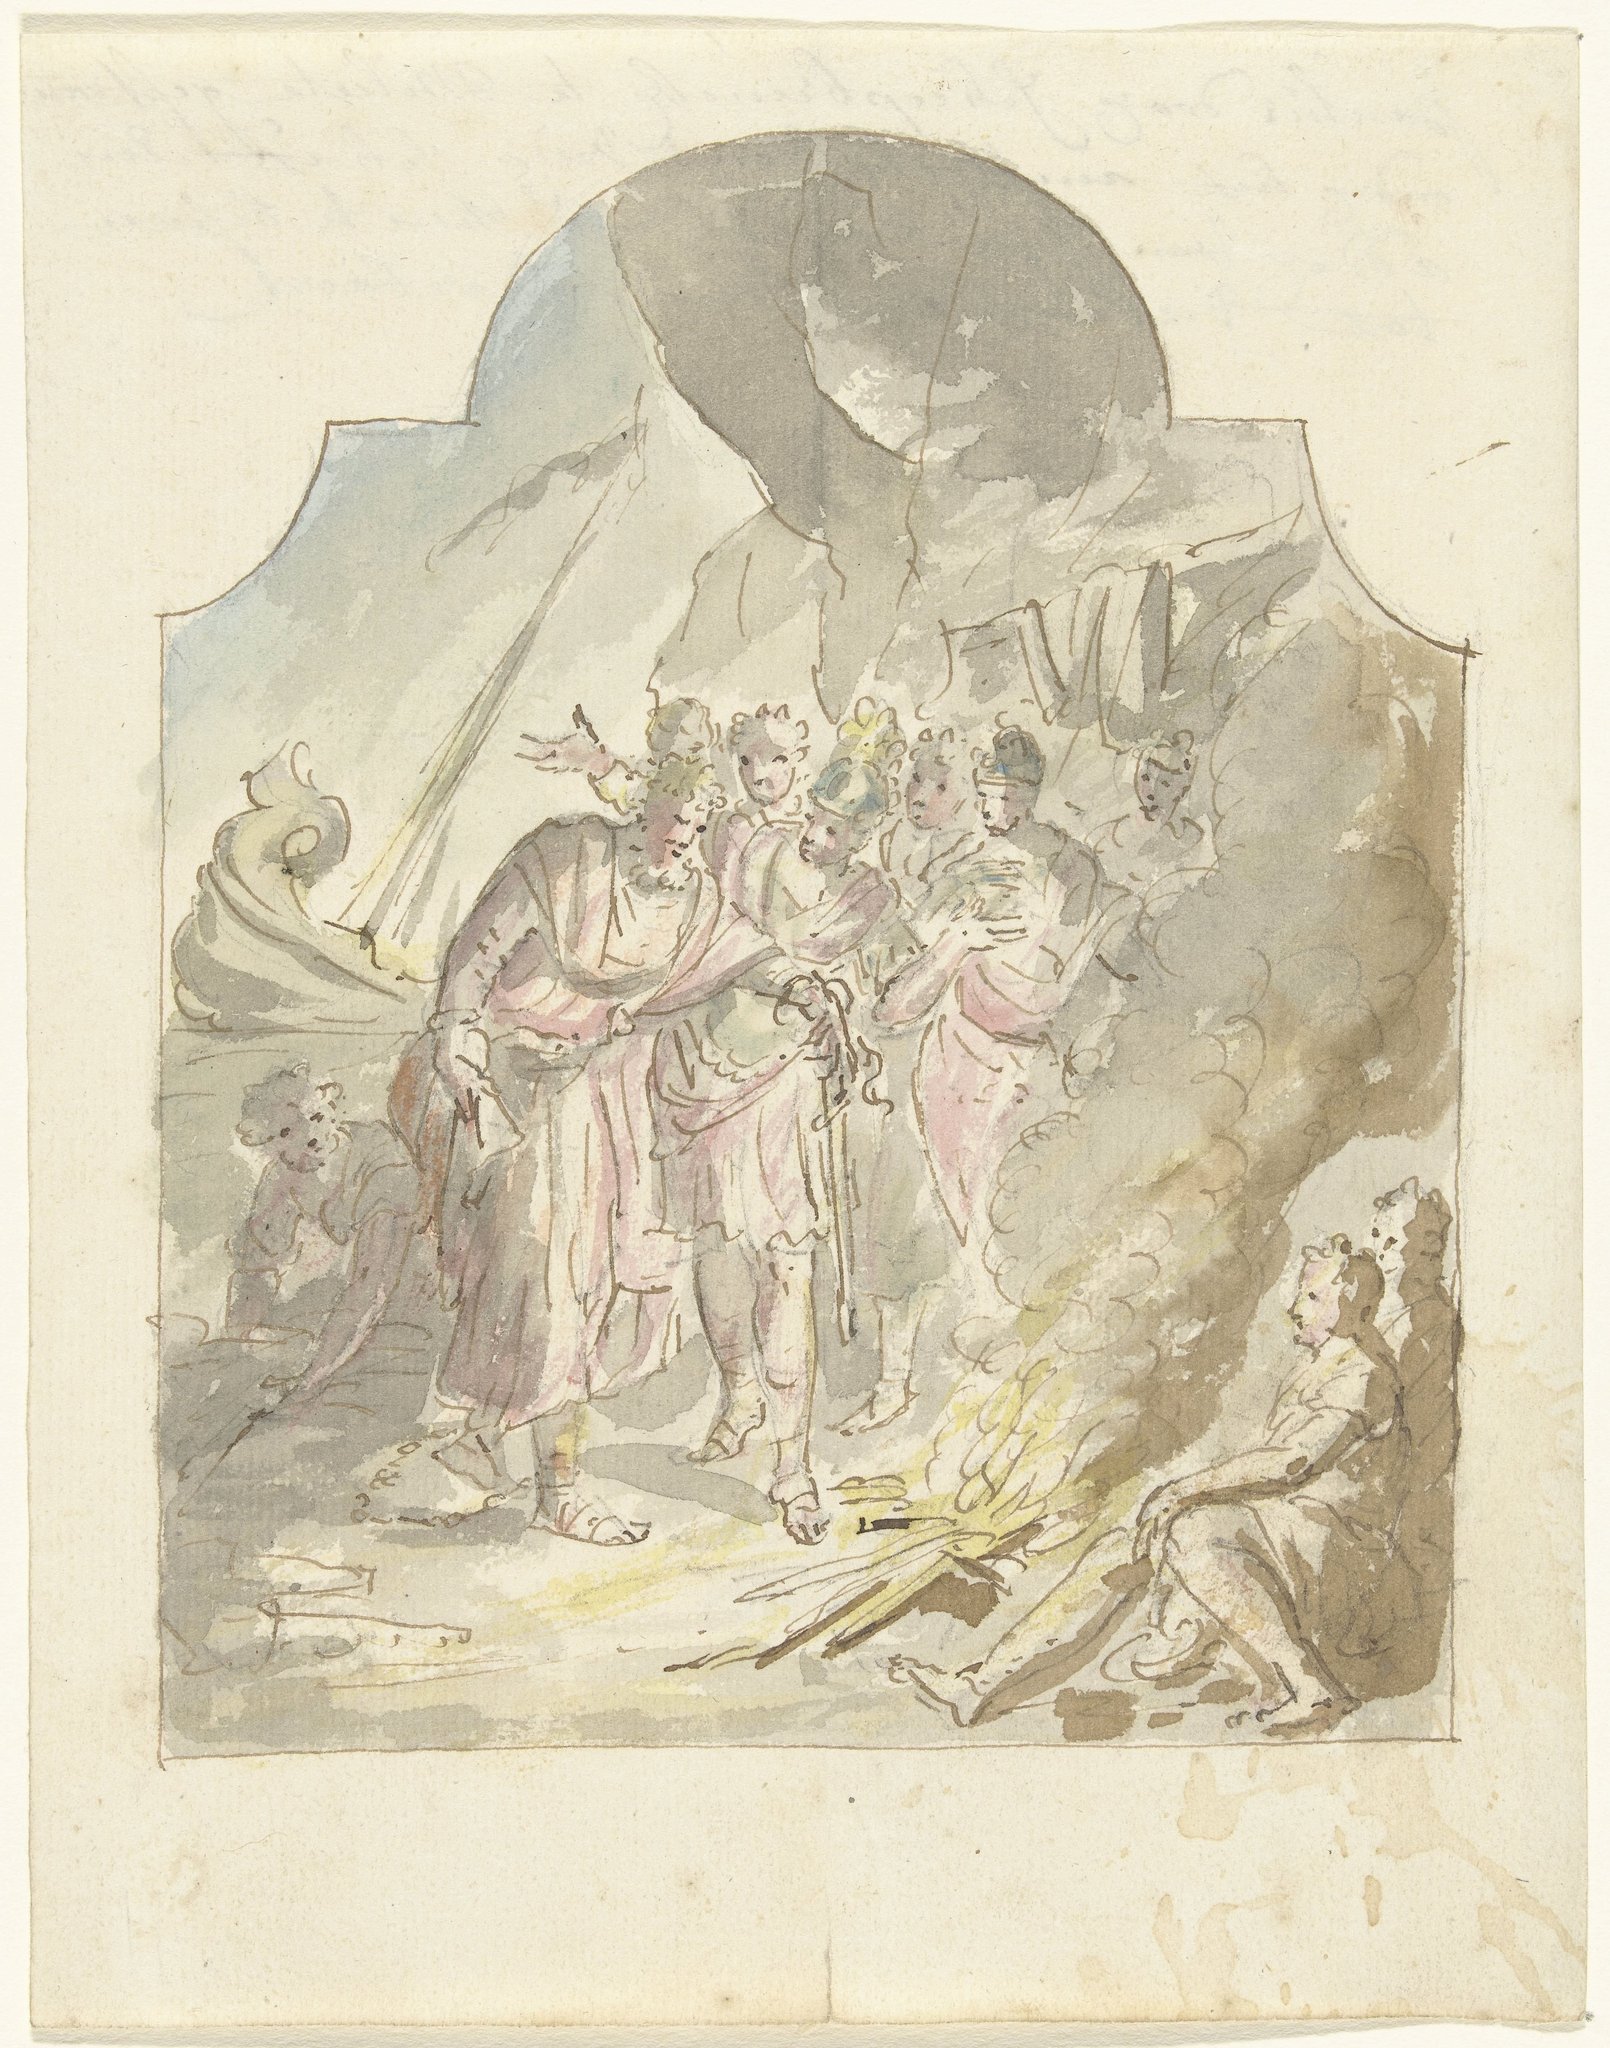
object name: design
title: Paulus wordt door een adder gebeten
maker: elias van nijmegen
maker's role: draughtsman, painter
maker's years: 1667-1755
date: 1677-1755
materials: ink, paper, pencil, watercolor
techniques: brush, pen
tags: paul bitten by a viper (when throwing wood on the fire)